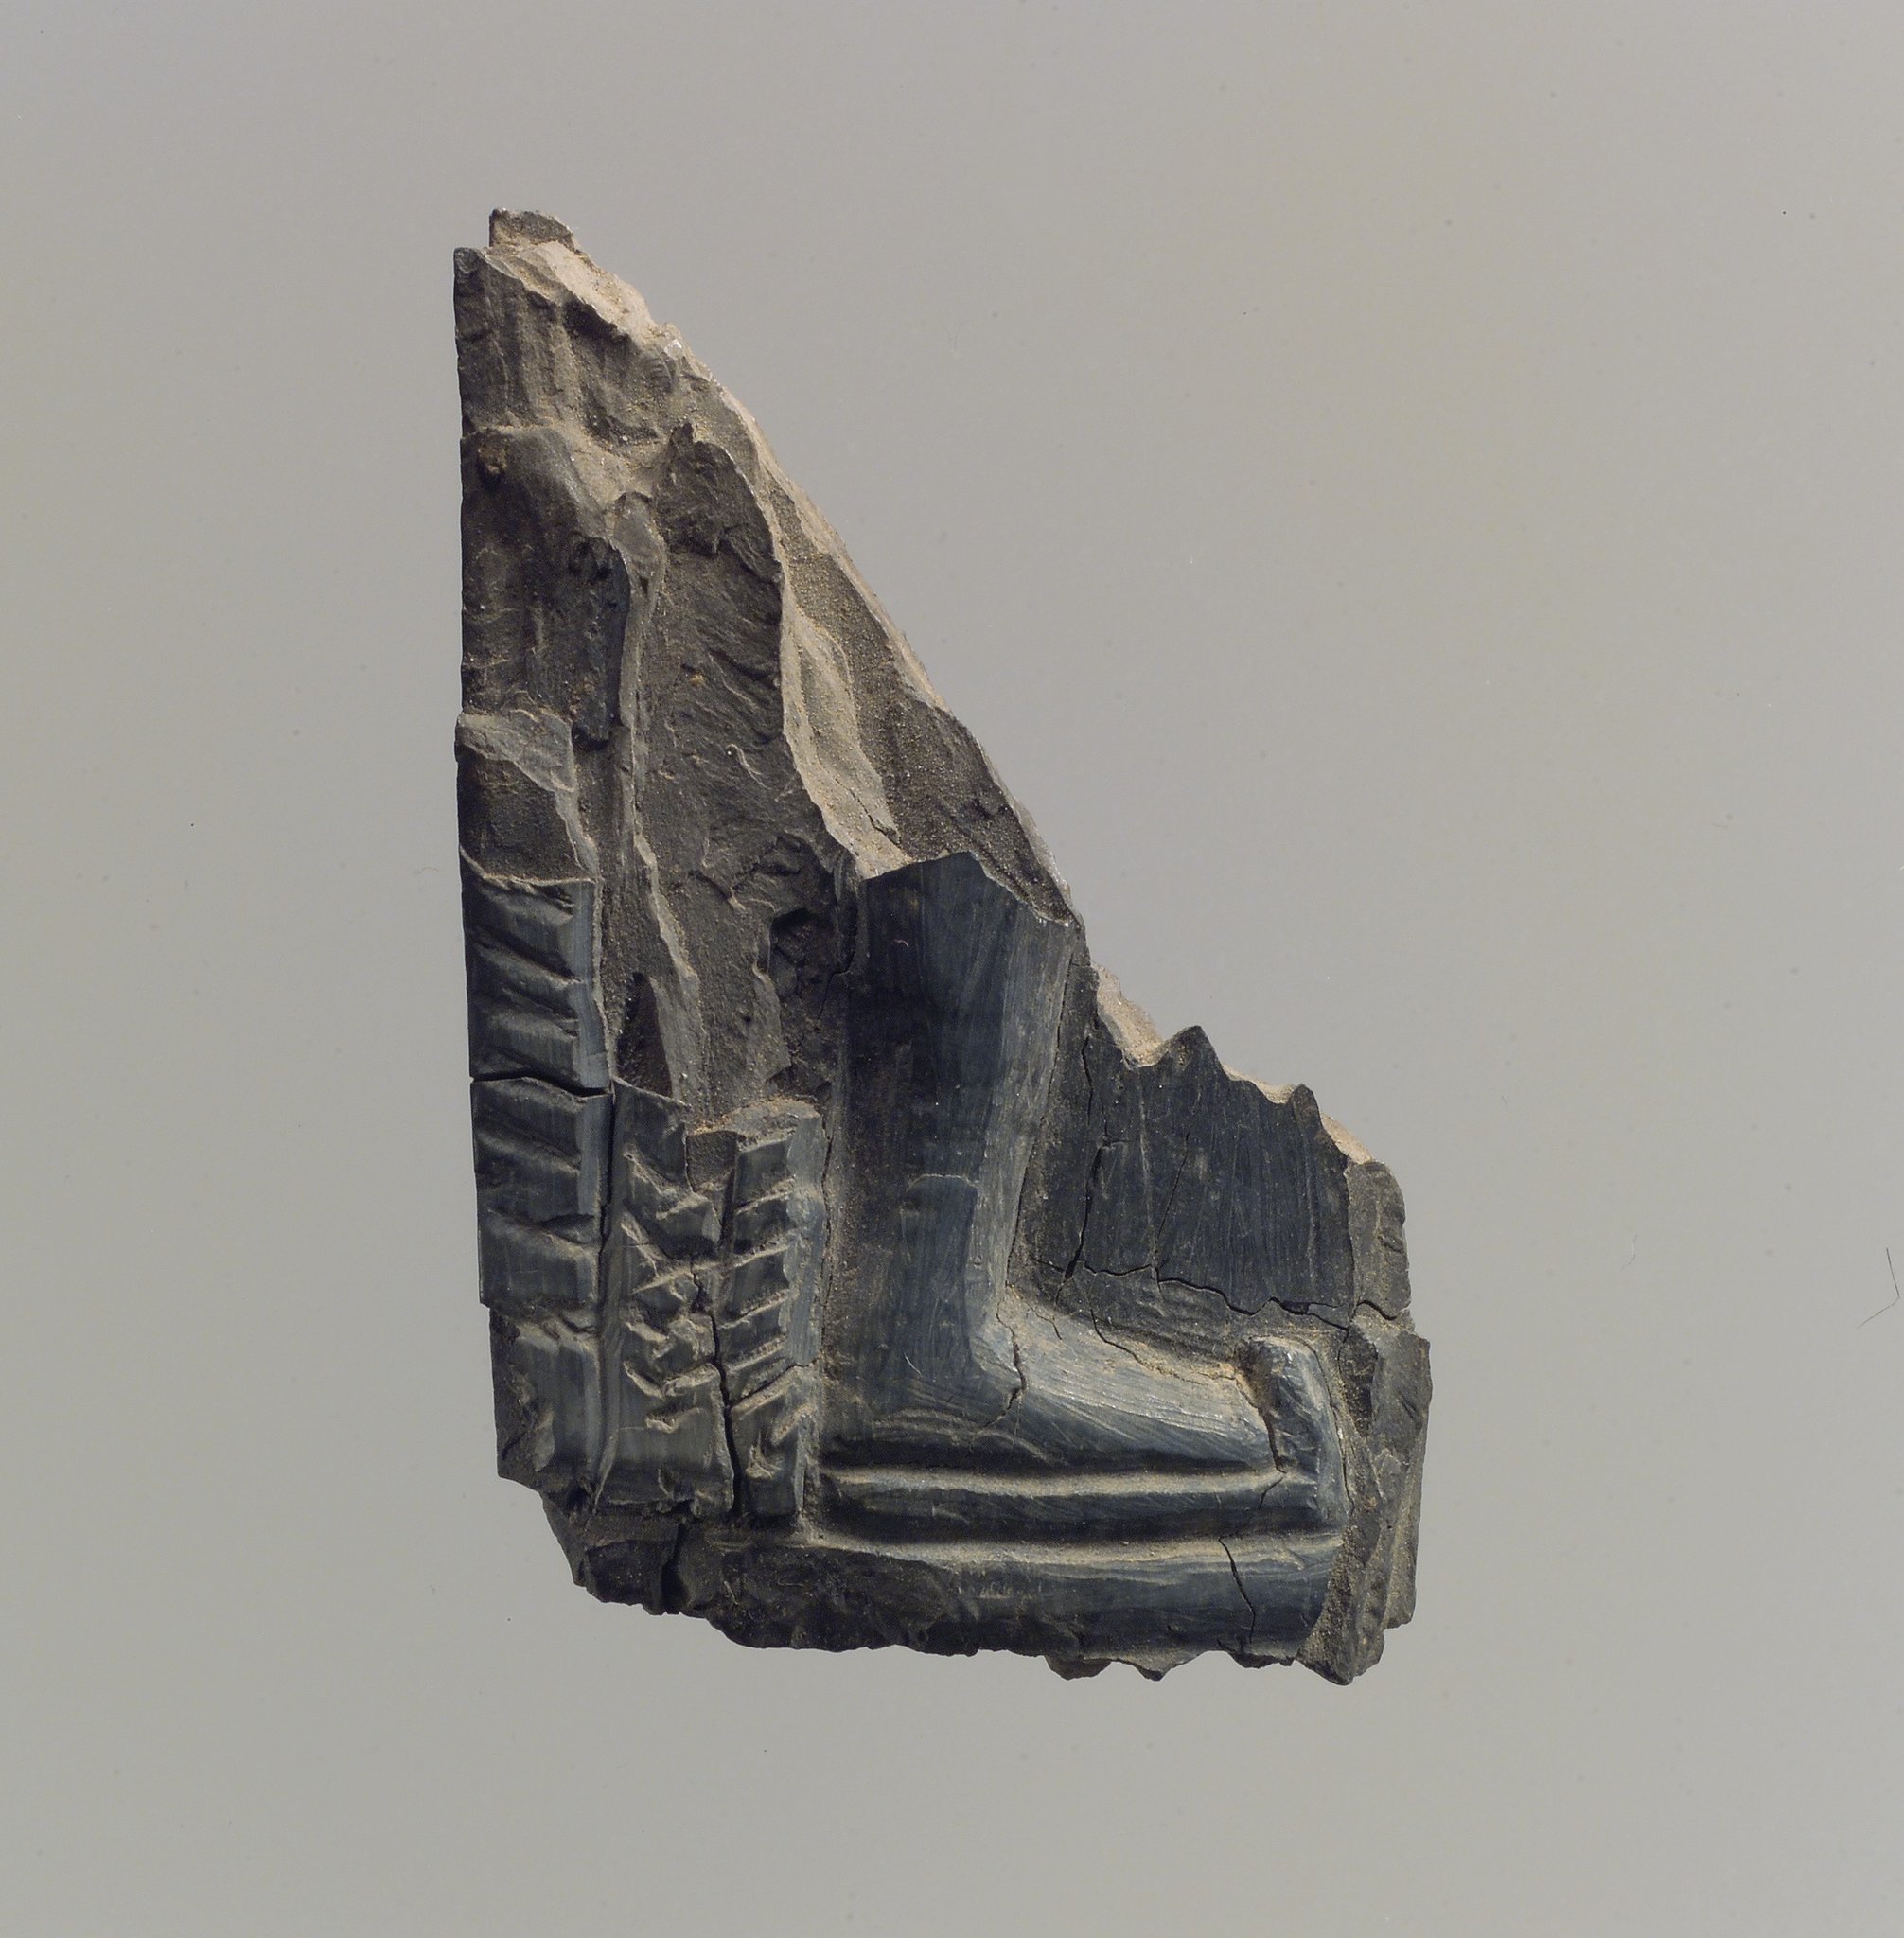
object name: relief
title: Plaque fragment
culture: iranian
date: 900-801 BCE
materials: ivory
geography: iran